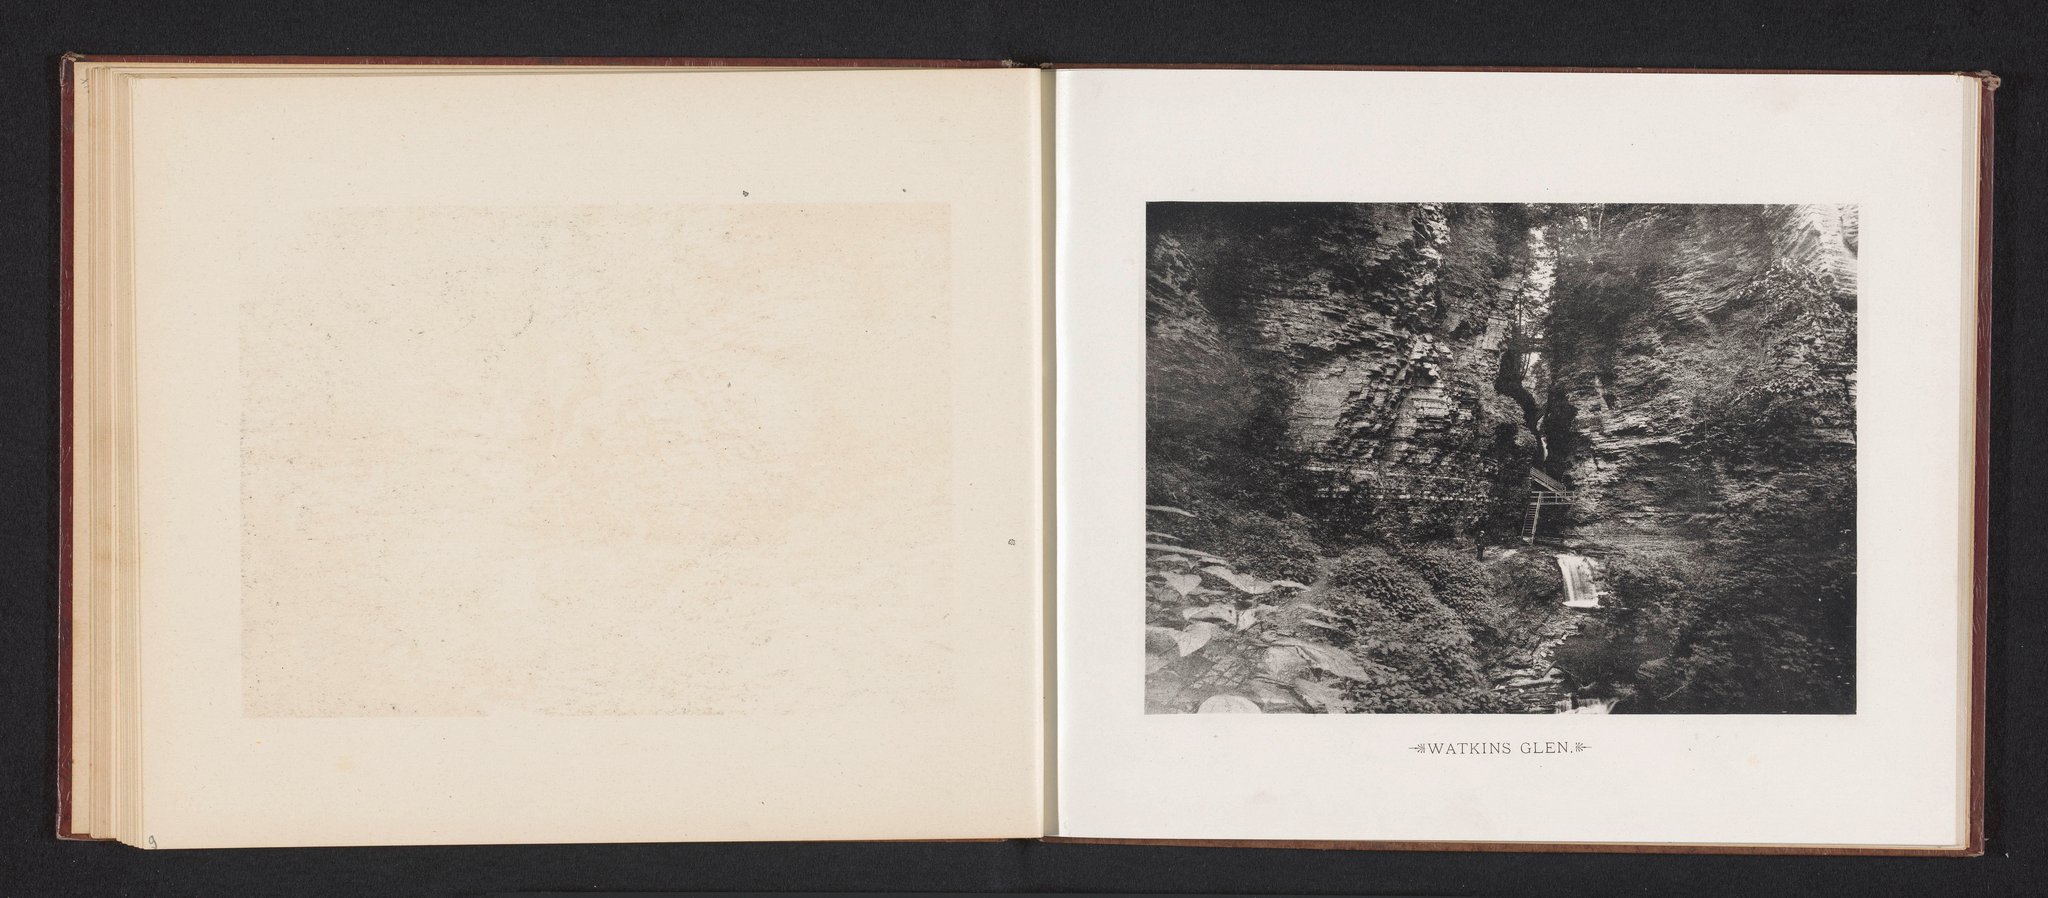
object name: page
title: Watkins Glen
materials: paper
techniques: photograph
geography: new york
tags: waterfall, ravine, chasm, abyss, canyon